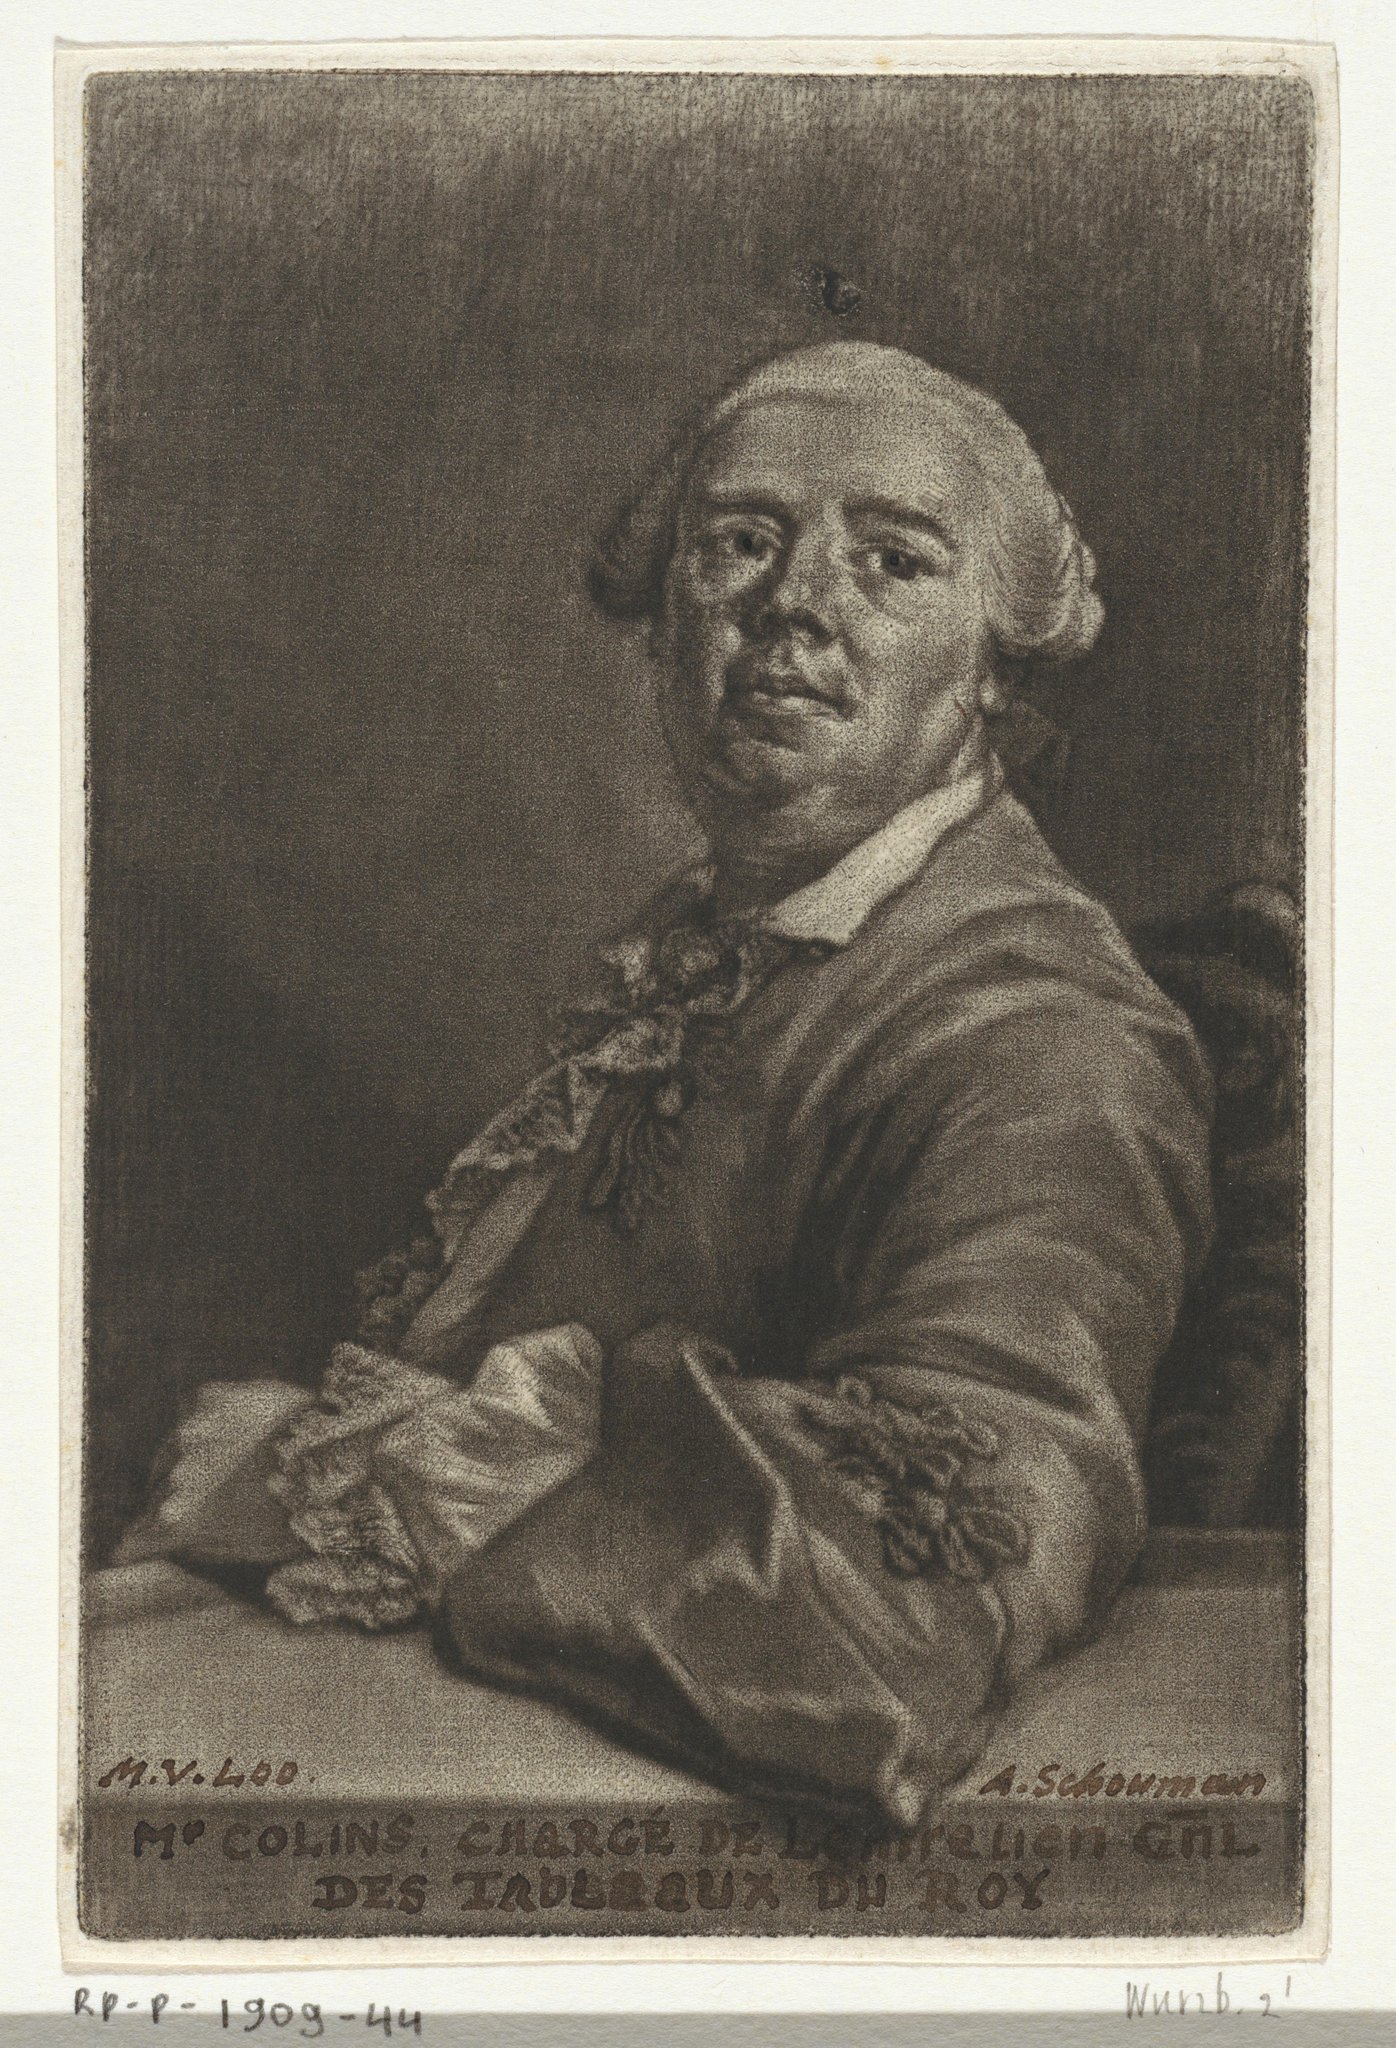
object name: print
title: Portret van François-Louis Colins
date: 1756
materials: paper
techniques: mezzotint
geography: the hague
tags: conservator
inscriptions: inscription: ‘M.v.Loo [...] Du Roy’, collector's mark: Lugt 2228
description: De Franse kunsthandelaar François-Louis Colins. Hij was vanaf 1743 conservator en restaurator van het Louvre.